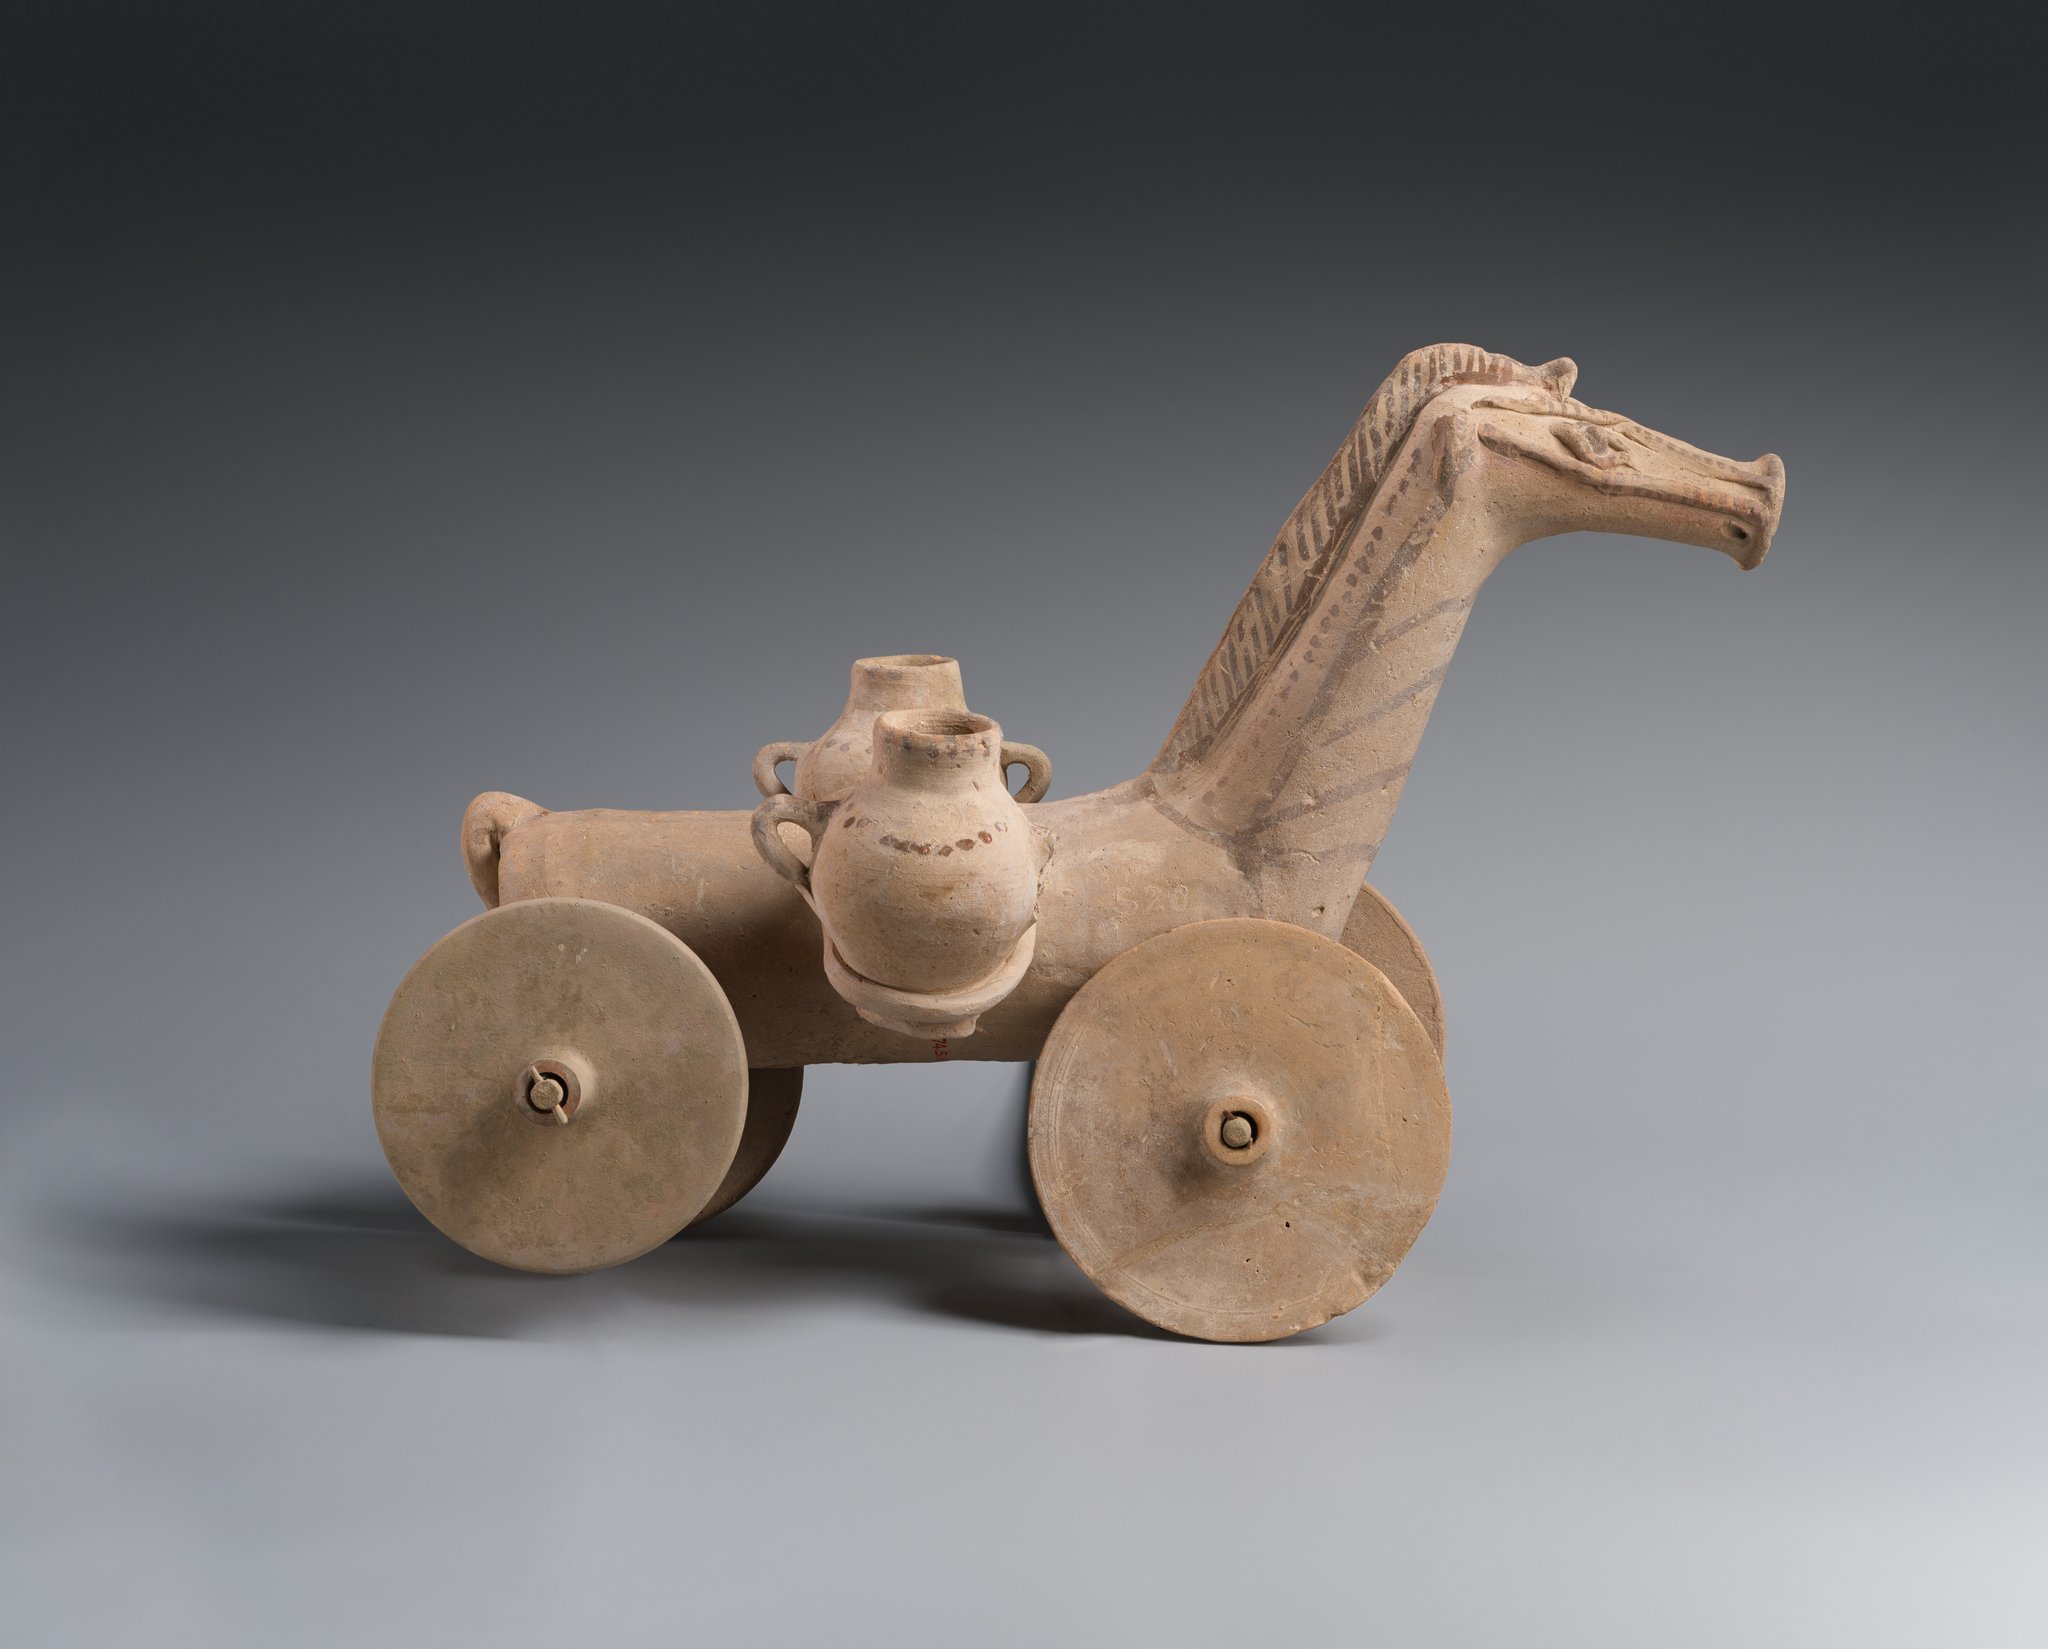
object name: vase in the form of a horse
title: Terracotta wheeled horse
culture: cypriot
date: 600-501 BCE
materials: terracotta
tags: horses